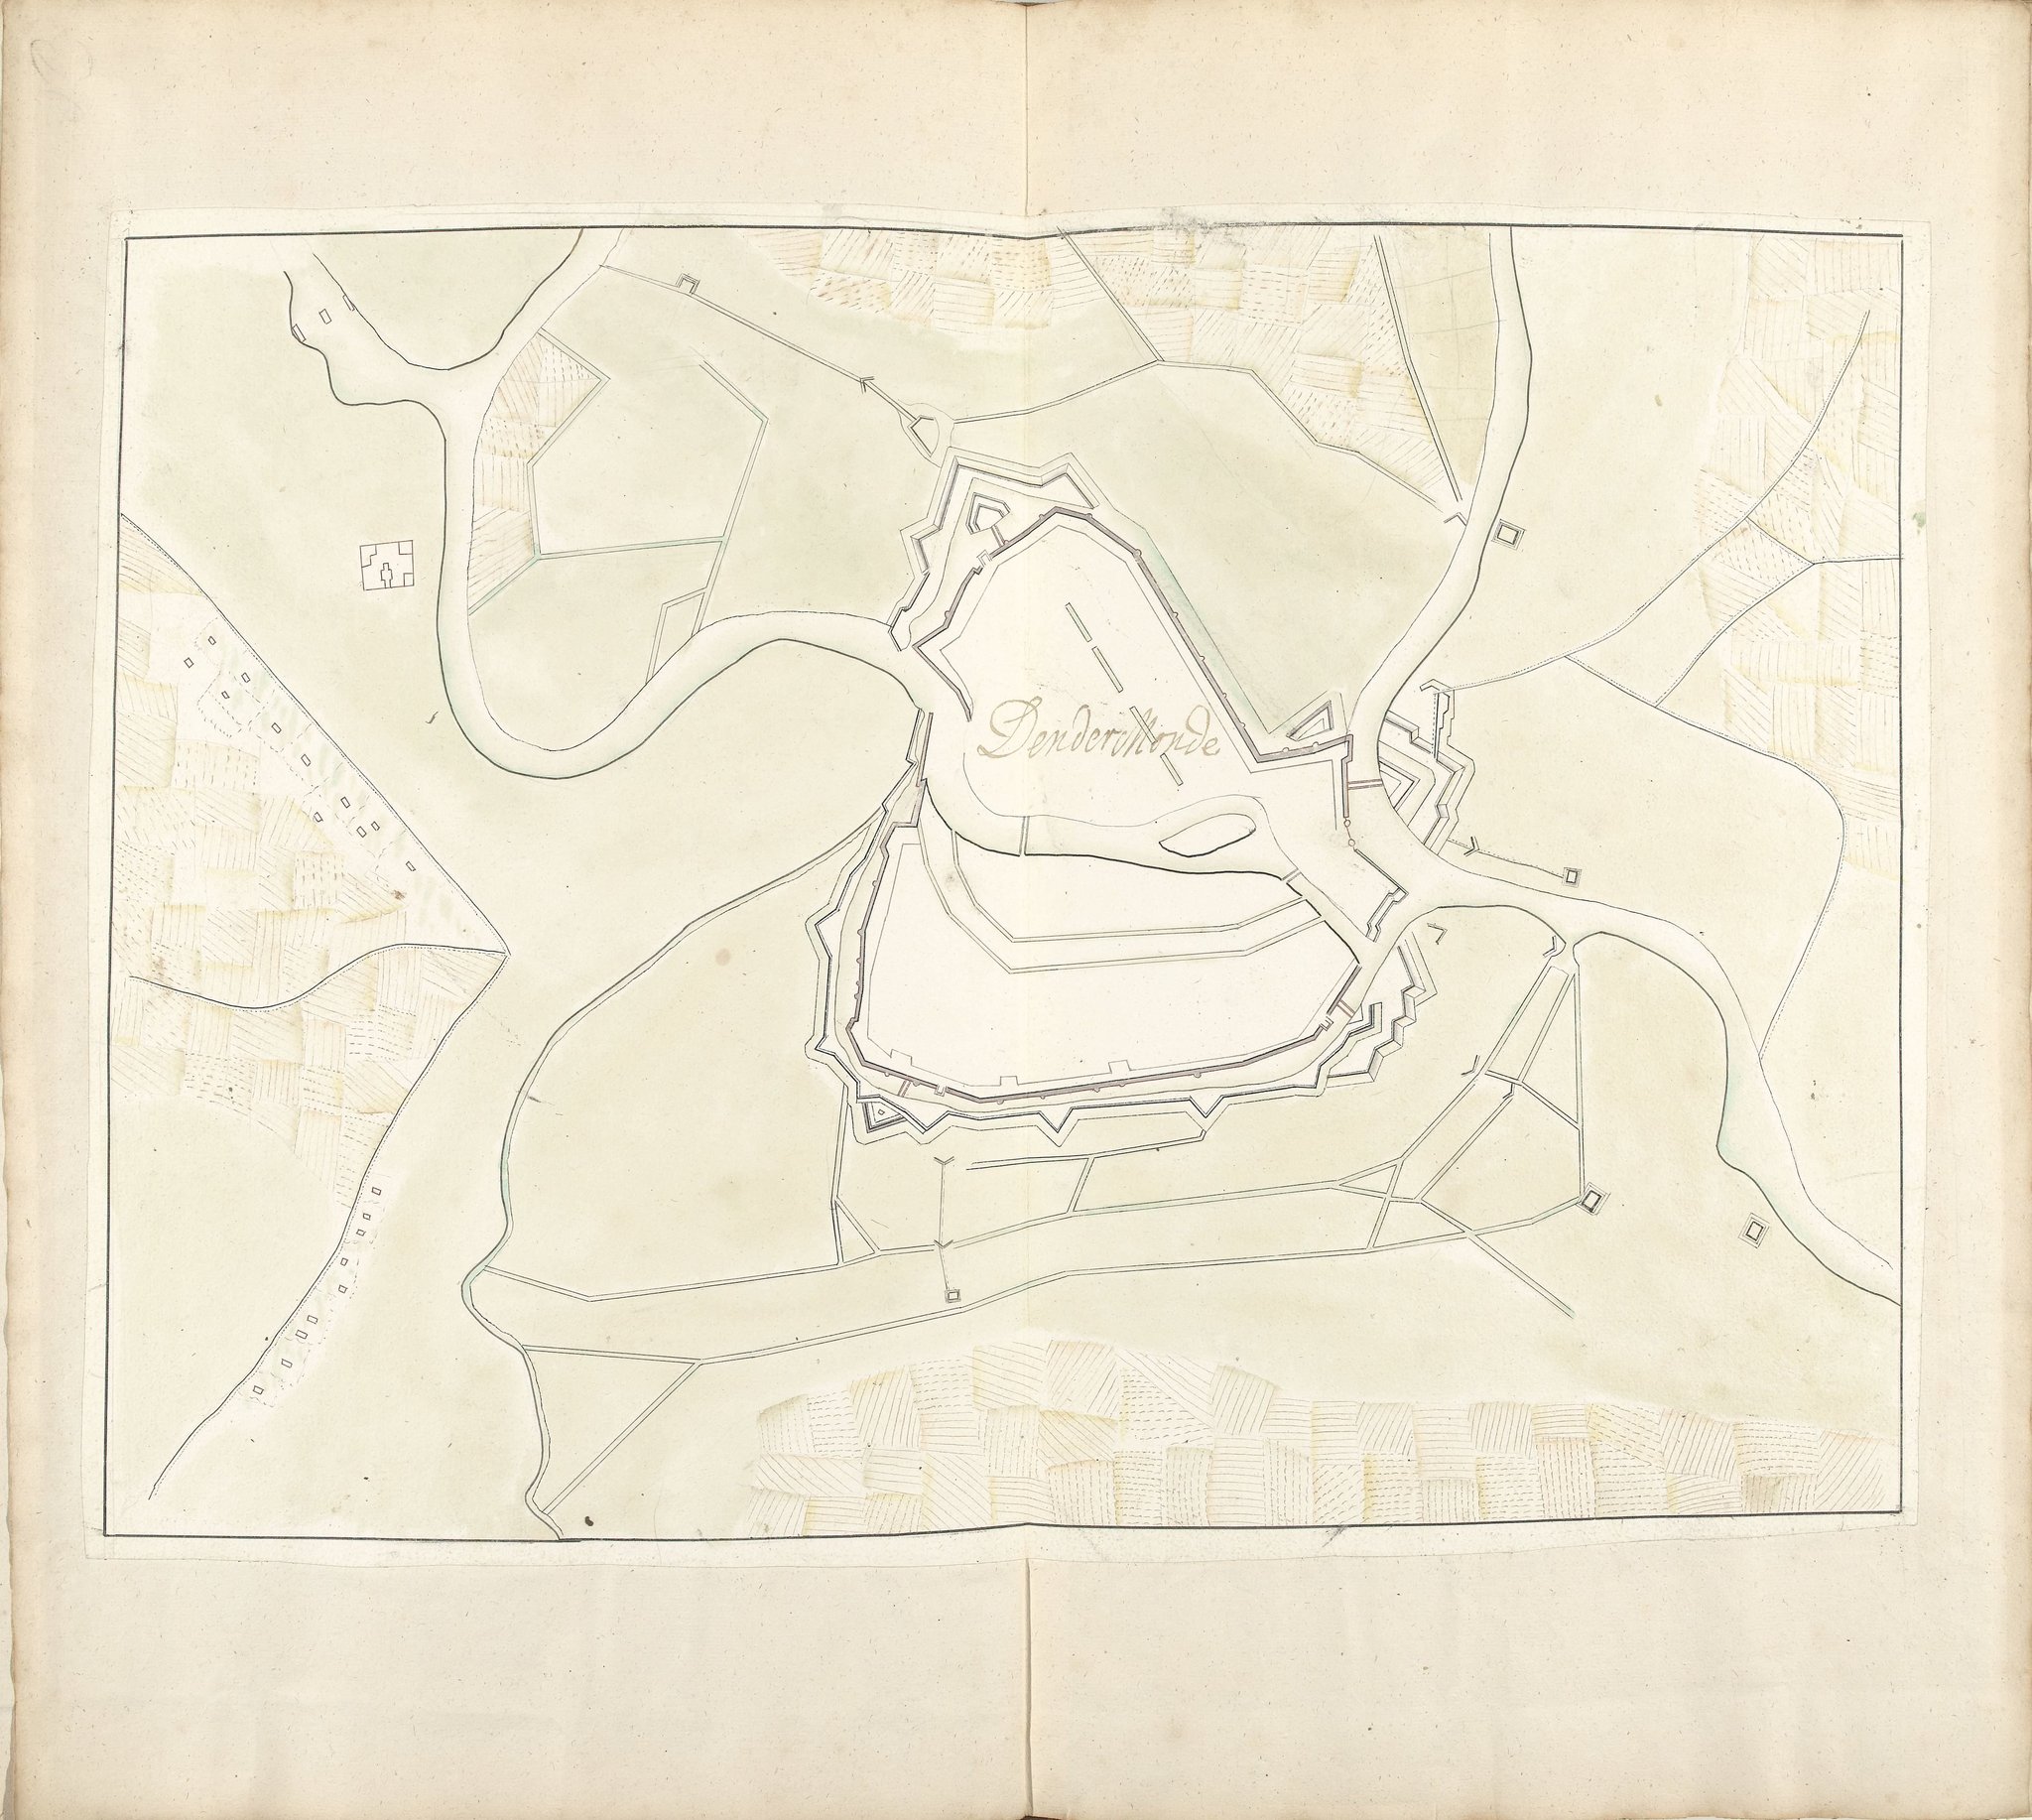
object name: drawing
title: Plattegrond van Dendermonde, ca. 1701-1715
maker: samuel du ry de champdoré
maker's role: draughtsman, engineer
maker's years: 1651-1729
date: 1701-1715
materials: paper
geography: netherlands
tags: fortress, maps of cities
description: Plattegrond van de versterkingen om de stad Dendermonde, ca. 1701-1715. Onderdeel van een verzameling getekende plannen van versterkte plaatsen in Nederland en omringende landen ten tijde van de Spaanse Successieoorlog (deel C).